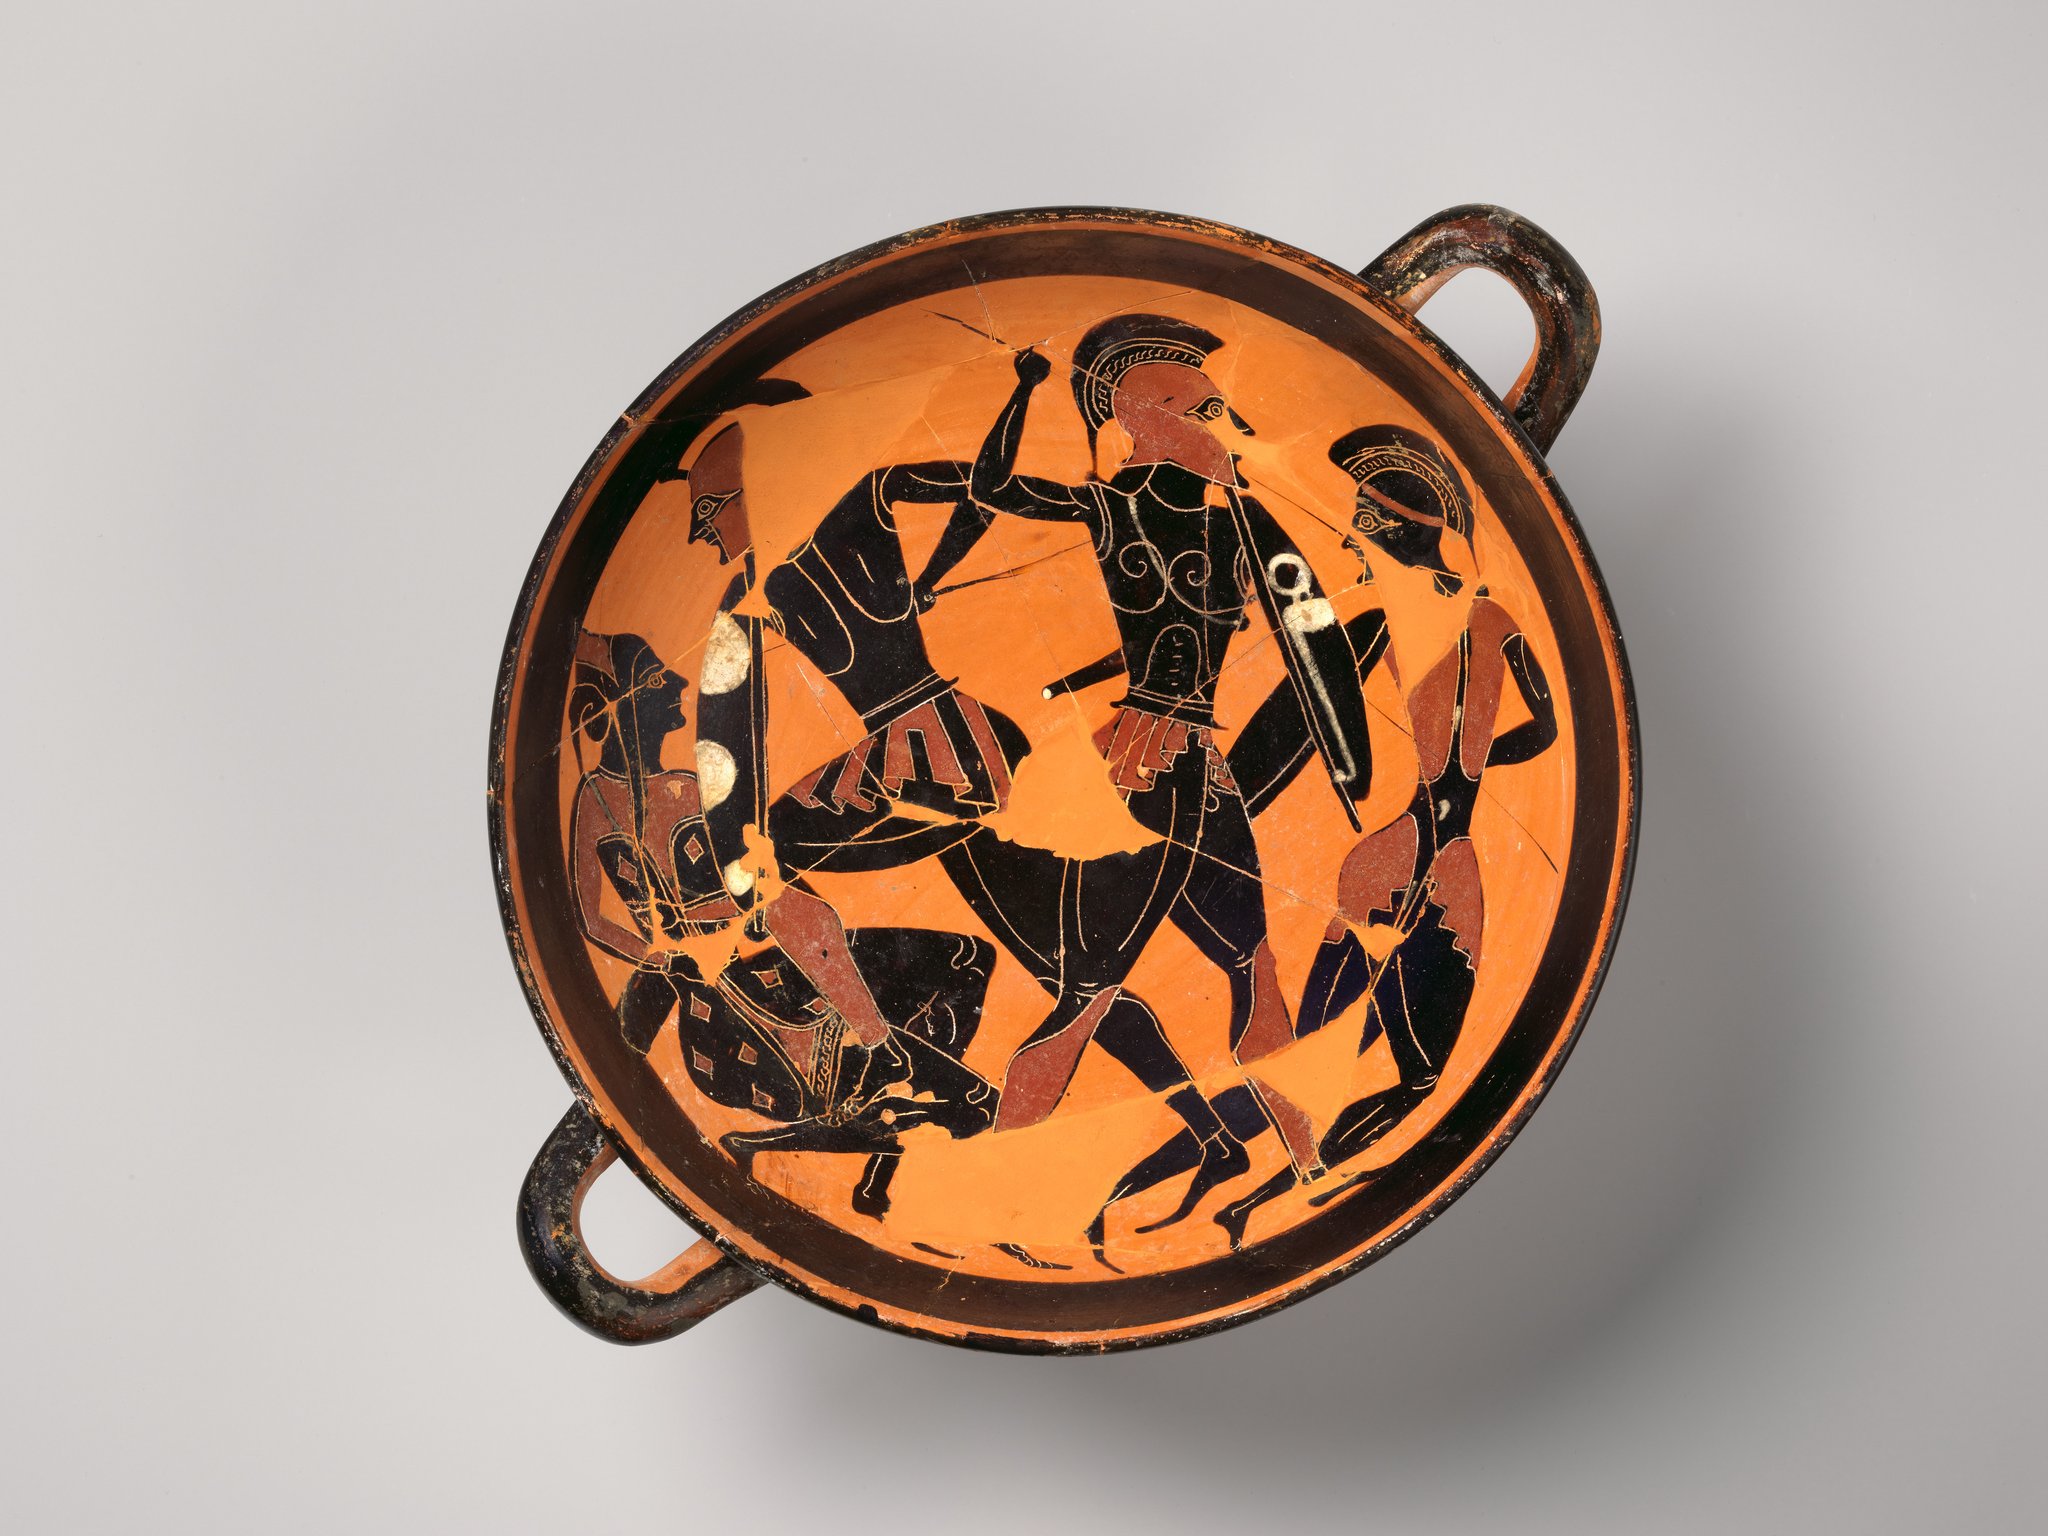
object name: kylix, eye cup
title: Terracotta kylix: eye-cup (drinking cup)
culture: greek, attic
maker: lydos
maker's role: artist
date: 540 BCE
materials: terracotta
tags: battles,eyes,men,sphinx